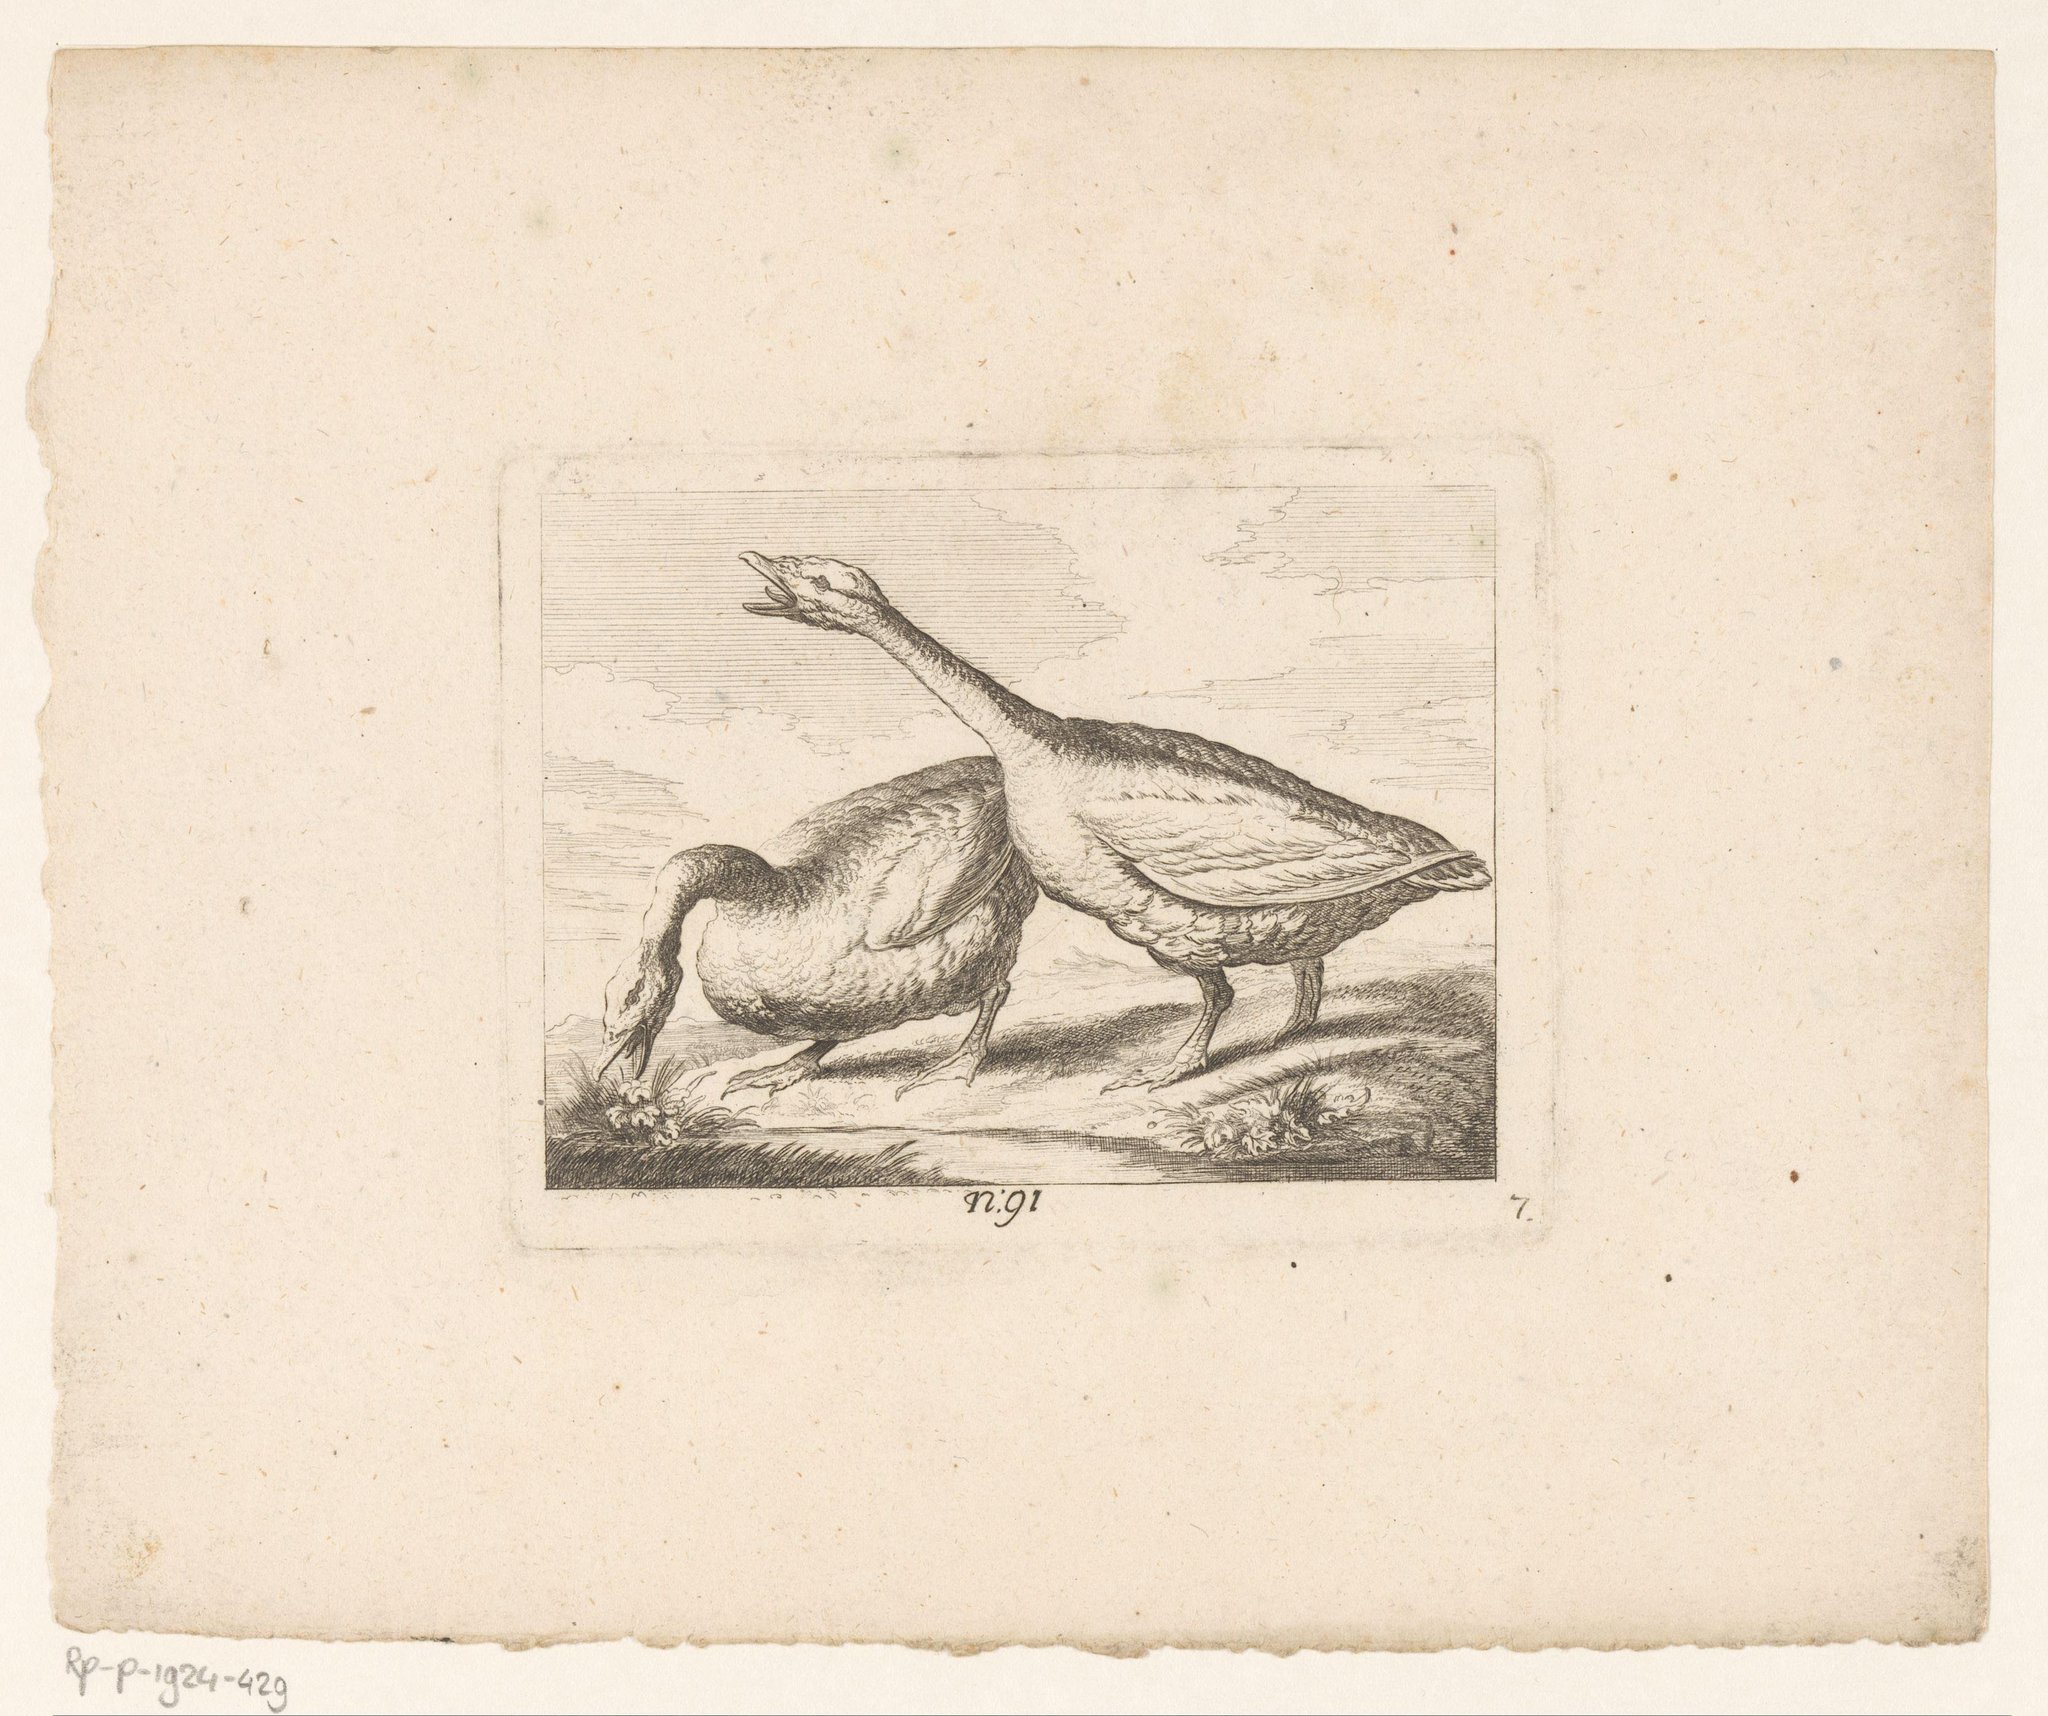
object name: print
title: Landschap met twee ganzen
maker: johann georg hertel (i)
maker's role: painter, print maker, publisher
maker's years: 1700-1775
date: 1705-1775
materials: paper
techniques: etching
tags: water-birds: goose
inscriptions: collector's mark: Lugt 2233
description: Onderdeel van een serie, waarvan prent één tot en met vijf en prent zeven aanwezig zijn bij het RMA.